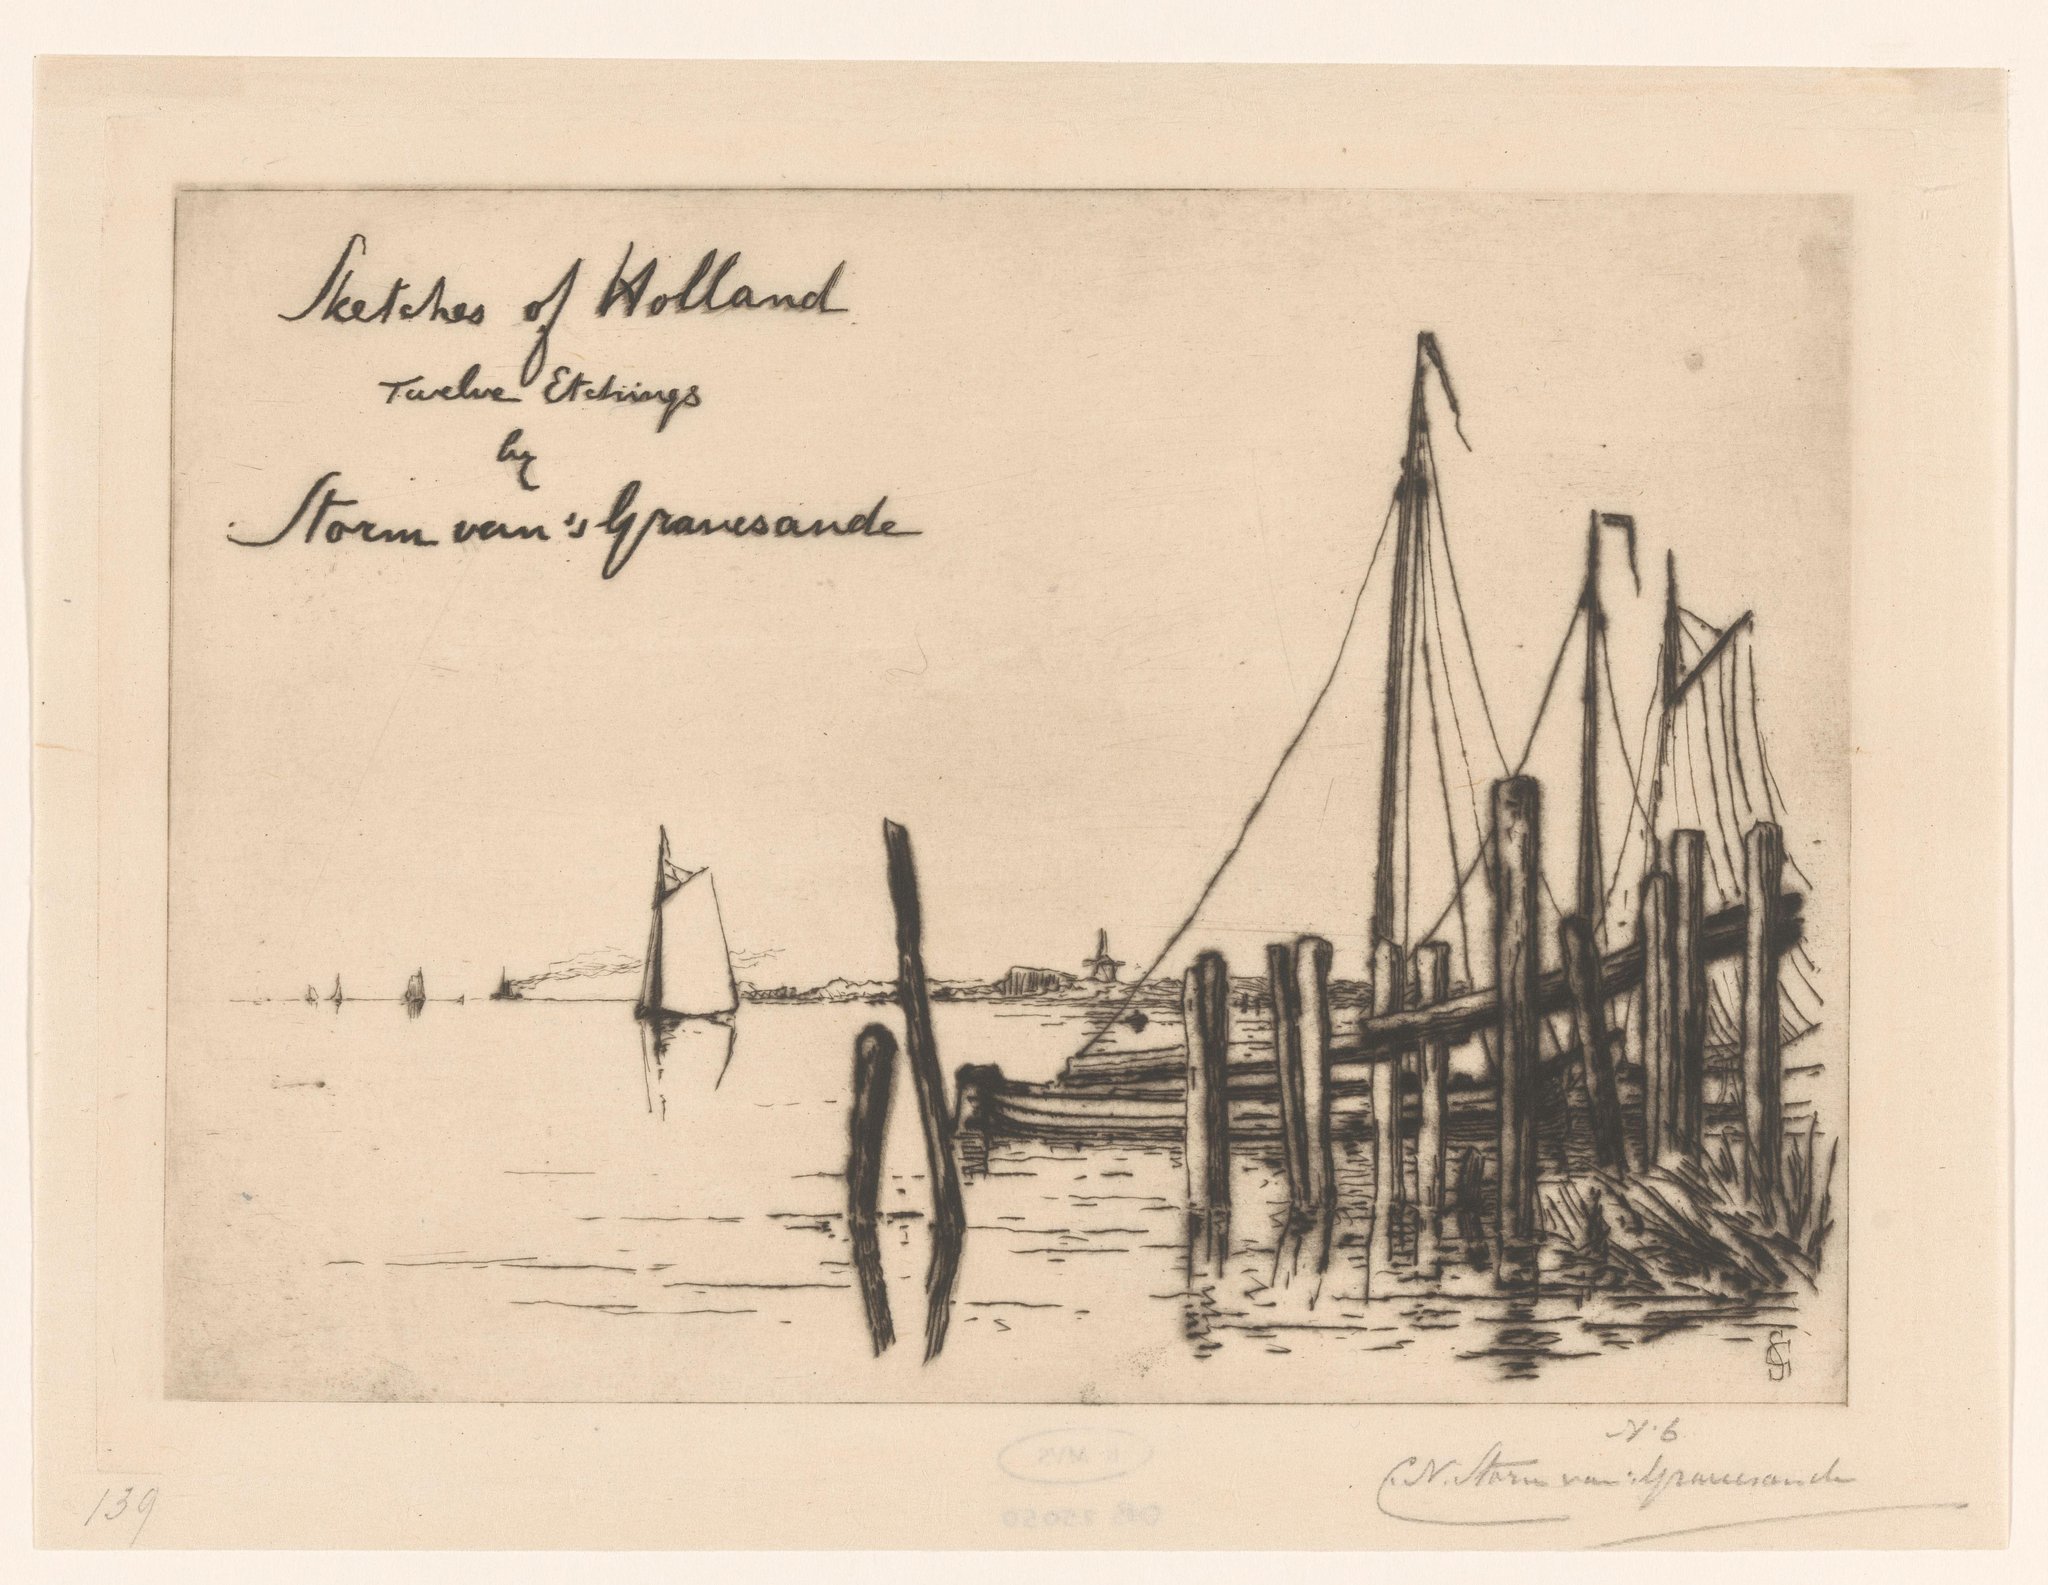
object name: titelprent, frontispice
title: Sketches of Holland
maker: carel nicolaas storm van s-gravesande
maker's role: draughtsman, print maker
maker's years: 1841-1924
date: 1880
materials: paper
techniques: drypoint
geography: netherlands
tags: river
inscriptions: number: ‘N. 6’, collector's mark: Lugt 2228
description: Riviergezicht met zeilboten. Linksboven de tekst: 'Sketches of Holland Twelve Etchings by Storm van 's Gravesande'.